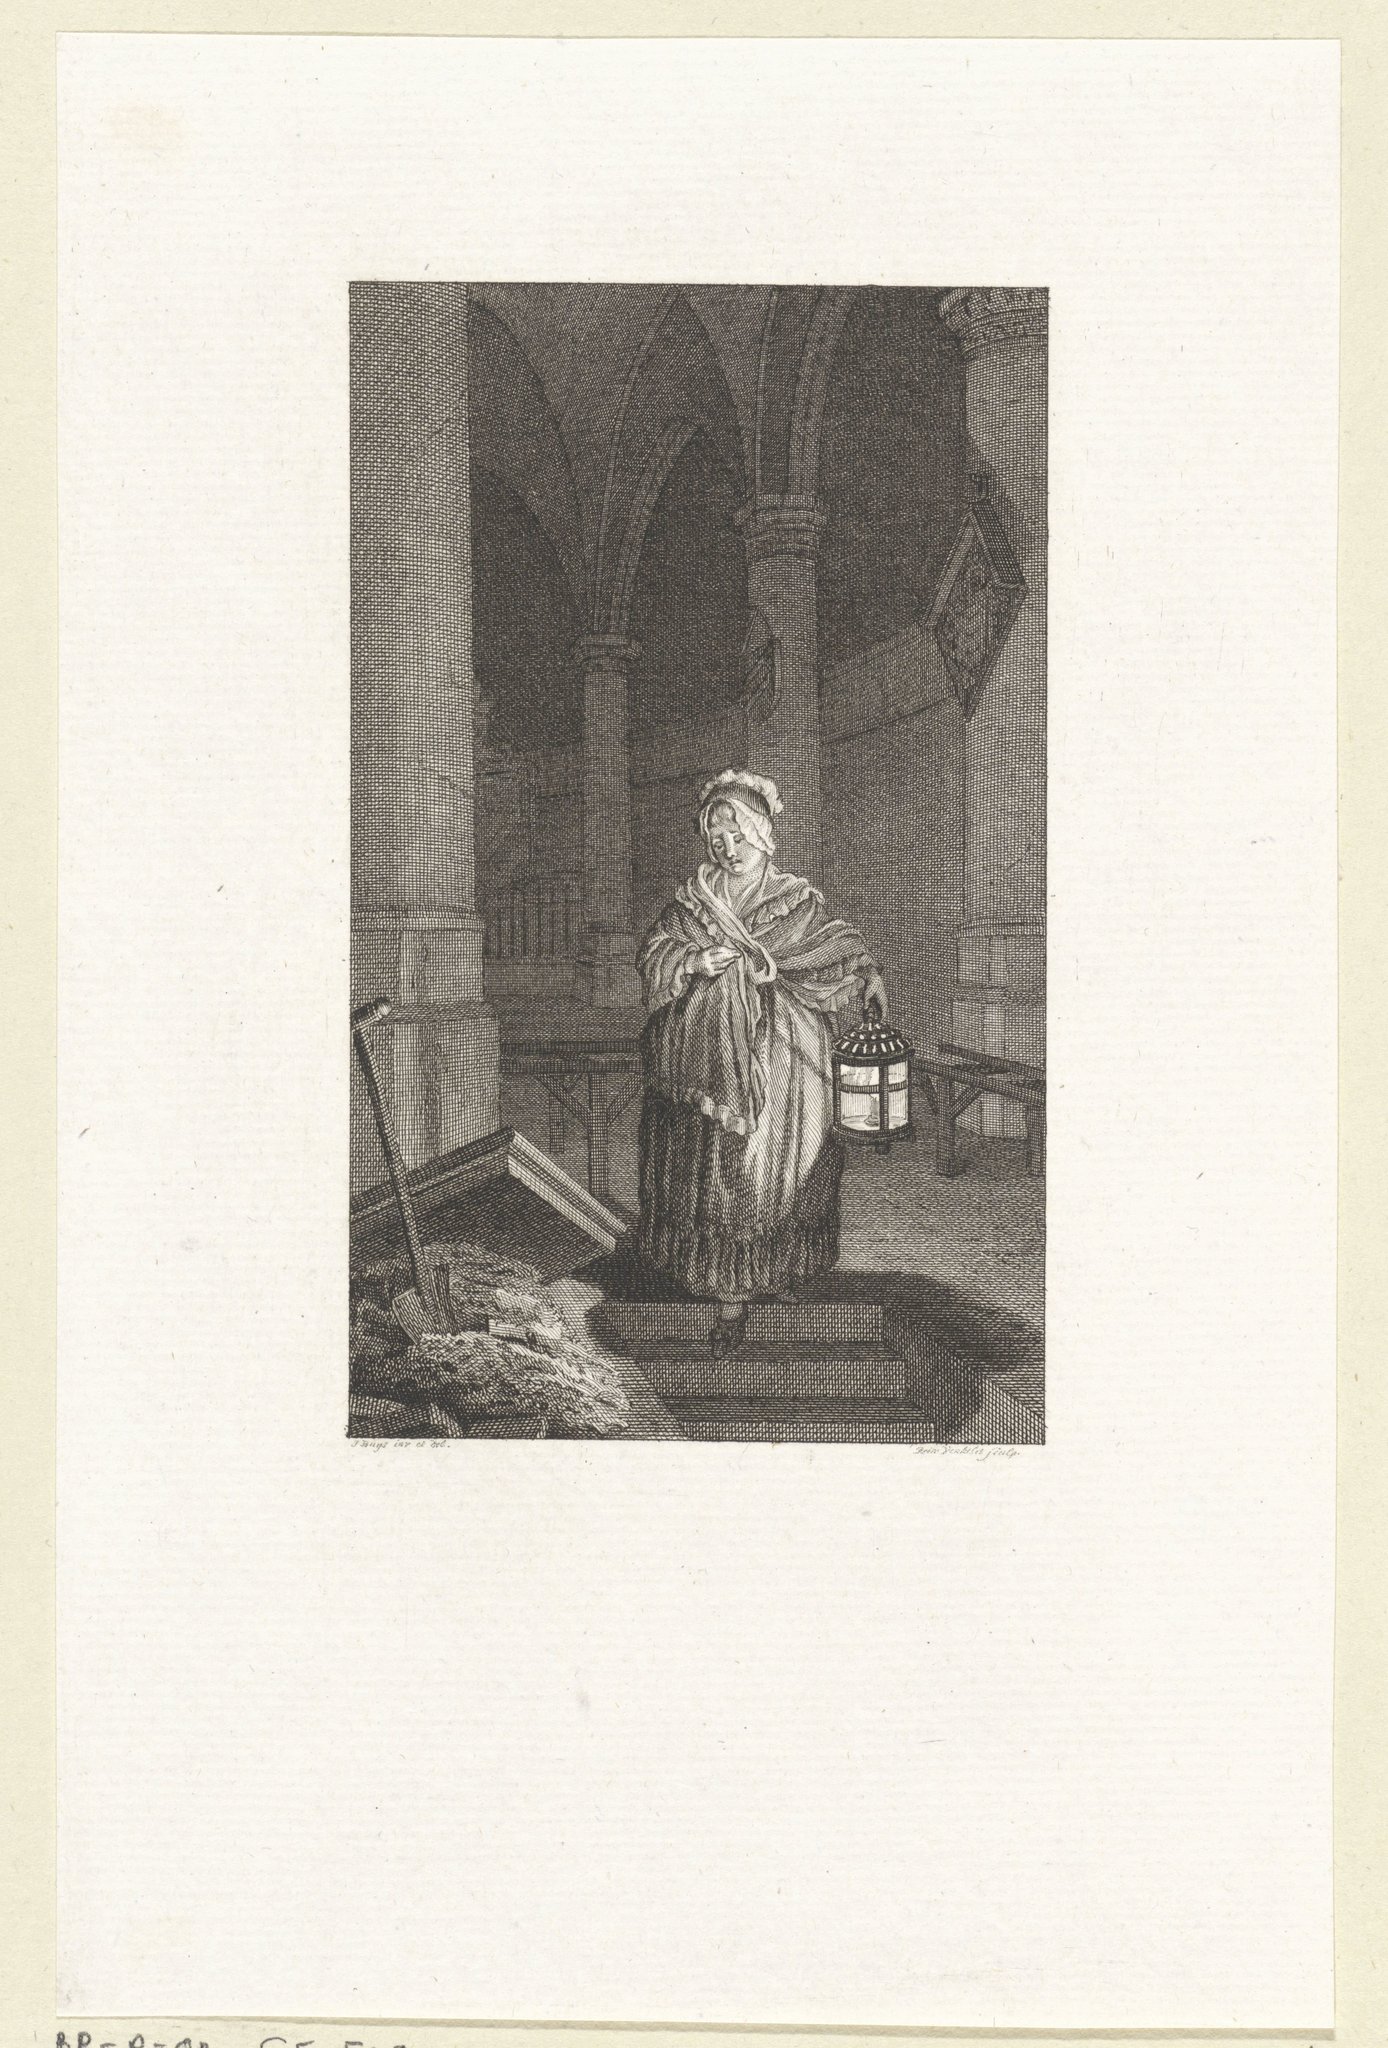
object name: print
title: In een kerk daalt een vrouw af in een graf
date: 1789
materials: paper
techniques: engraving, etching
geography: amsterdam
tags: grave, tomb, interior of church, lantern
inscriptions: collector's mark: Lugt 240